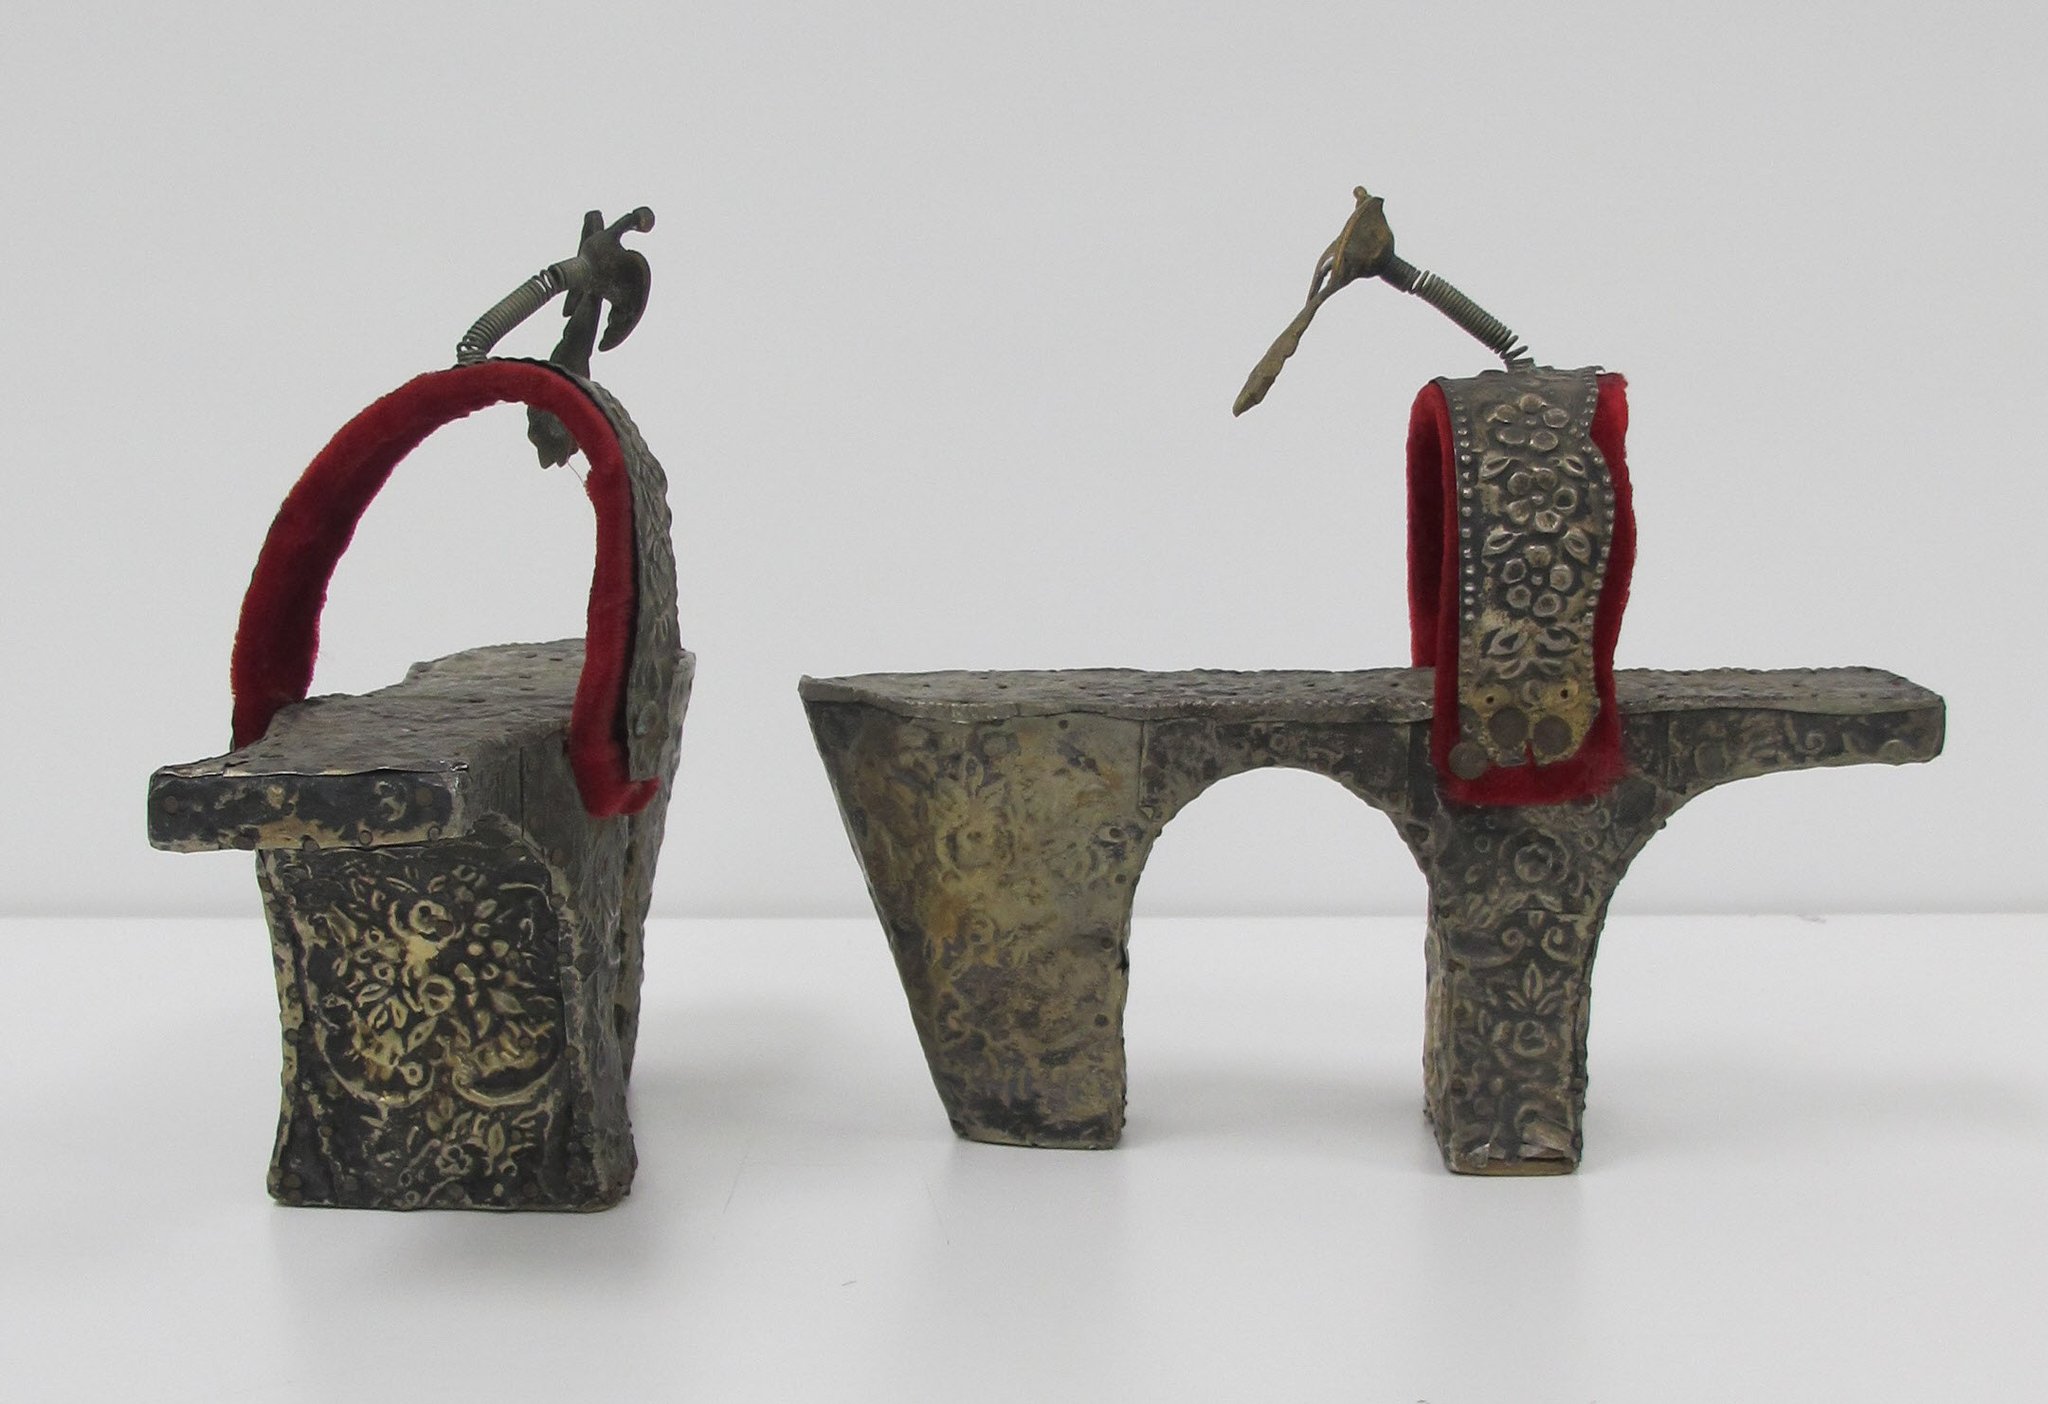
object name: shoe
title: Hammam Shoes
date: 1867-1900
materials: metal, wood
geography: turkey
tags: footwear